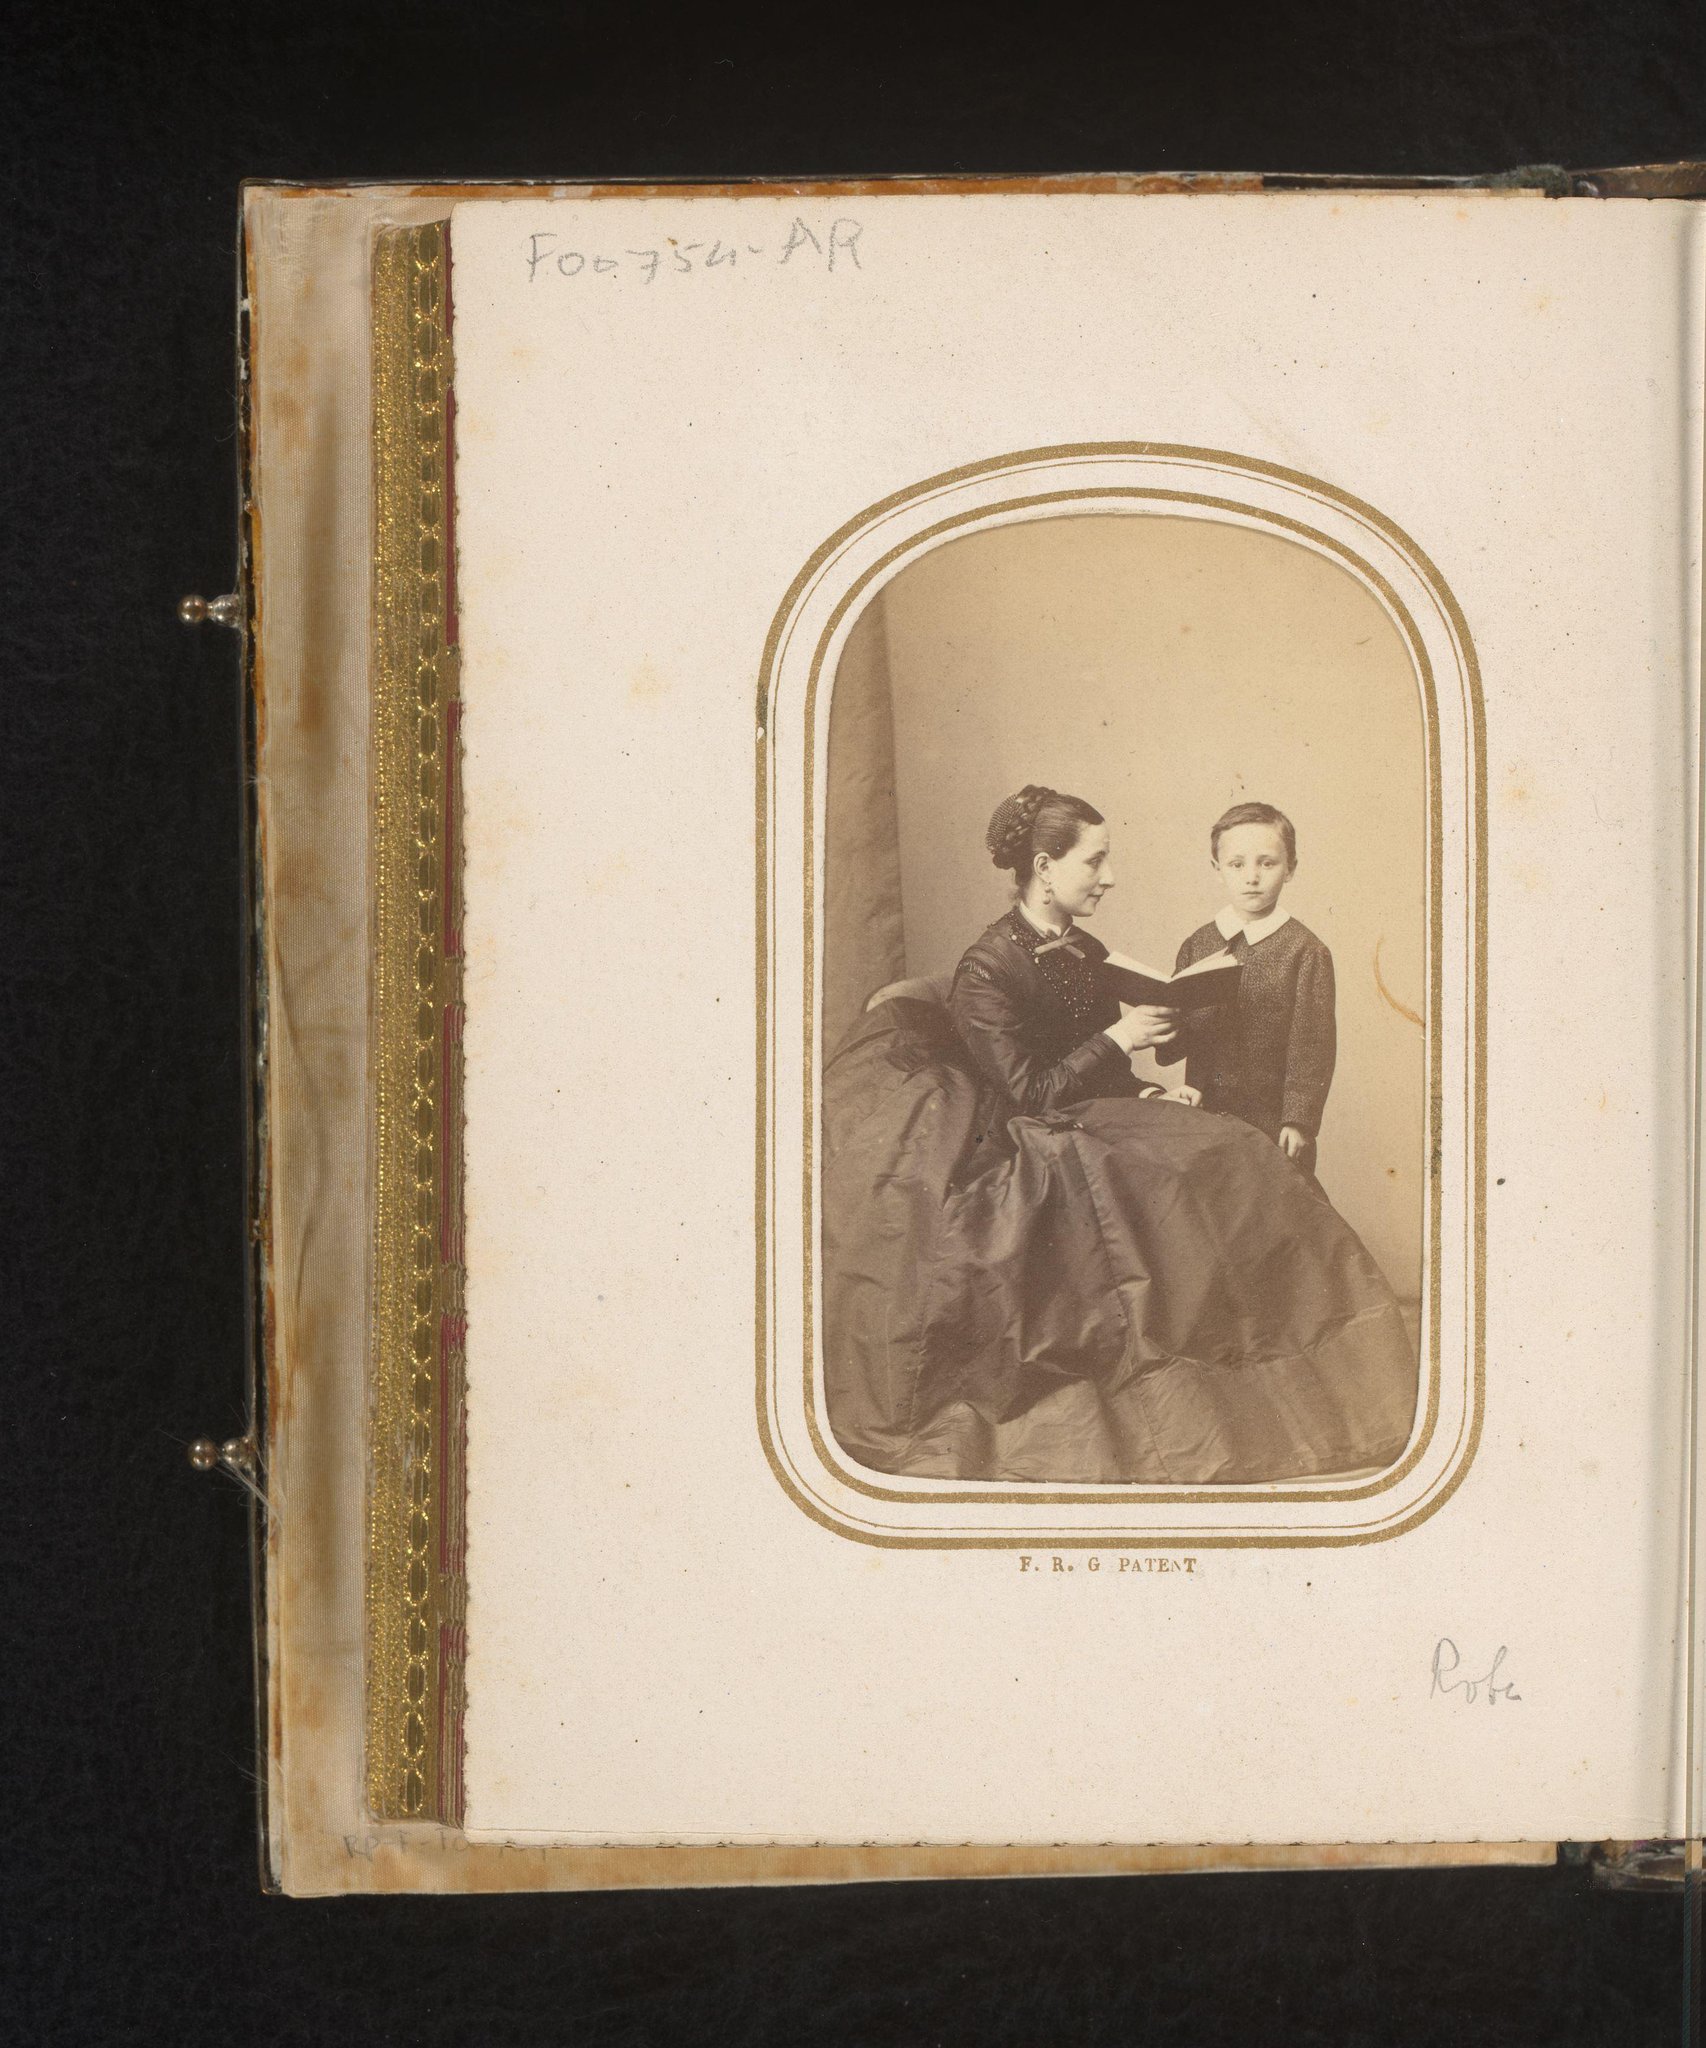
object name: album leaf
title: Portret van een jongen, staand naast een zittende vrouw met open boek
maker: n. robe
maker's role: fotograaf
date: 1855-1880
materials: cardboard, photographic support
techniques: albumen print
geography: paris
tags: historical persons - bb - woman, boy (child between toddler and youth)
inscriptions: number: ‘7942’, inscription: ‘Photographie Rossini/ N. Robe/ Bté s.g.d.g./ 20, rue Rossini, 20./ à l'angle de la rue Laffite/ Paris’